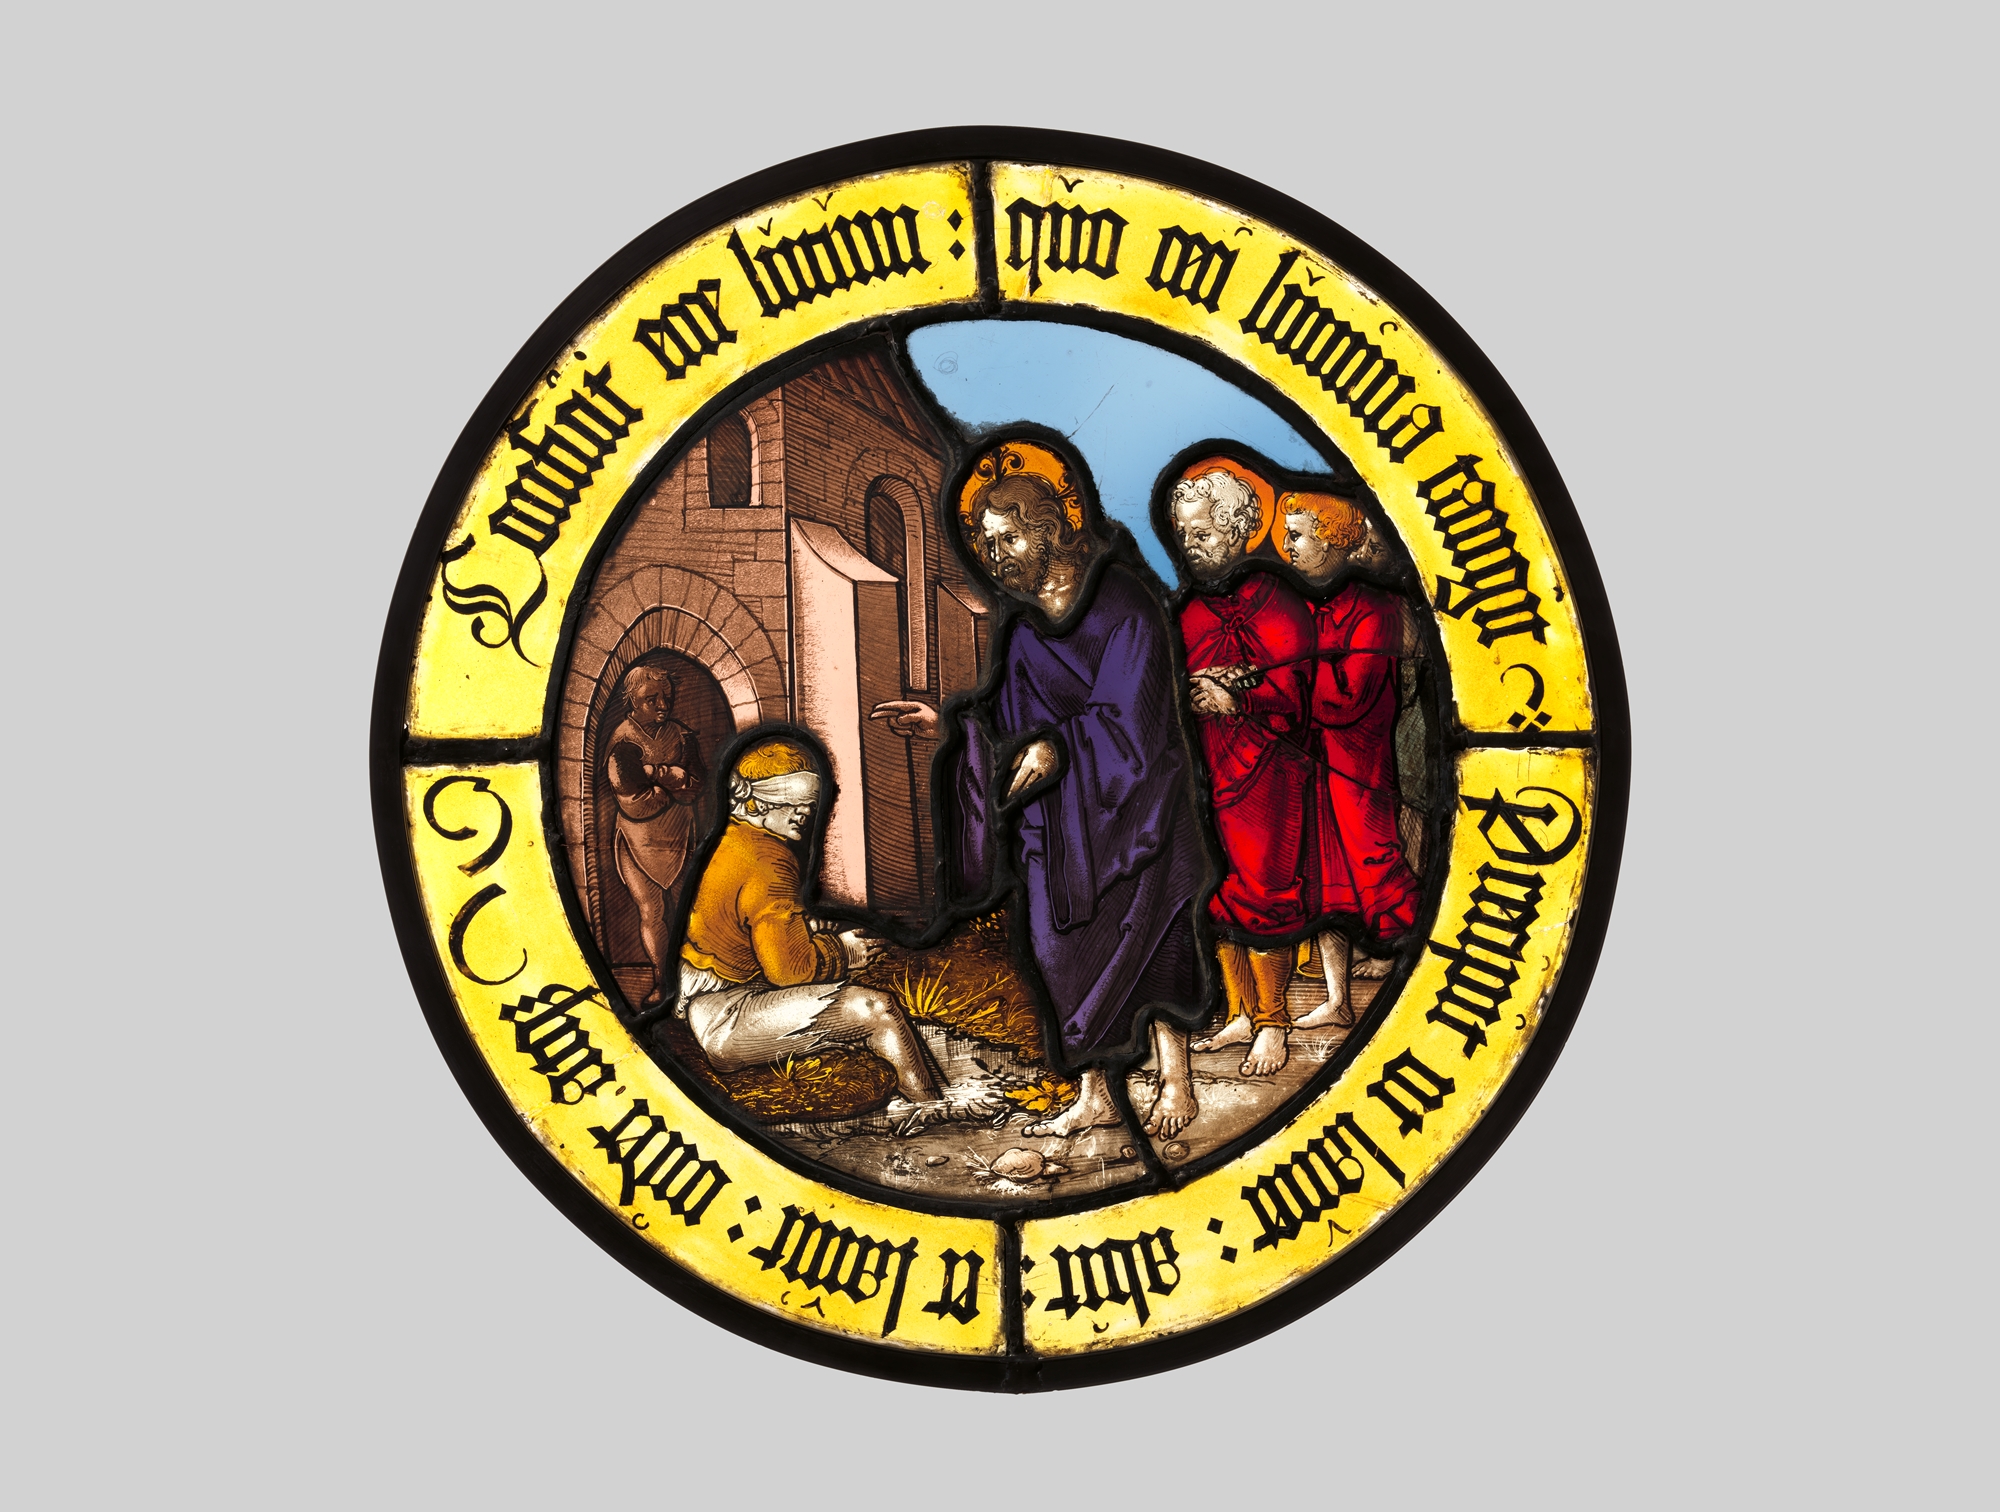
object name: roundel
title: Roundel with Christ Healing the Blind Man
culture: german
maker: hirschvogel workshop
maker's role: artist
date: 1517-1527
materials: glass, metal, paint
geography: germany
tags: men,christ